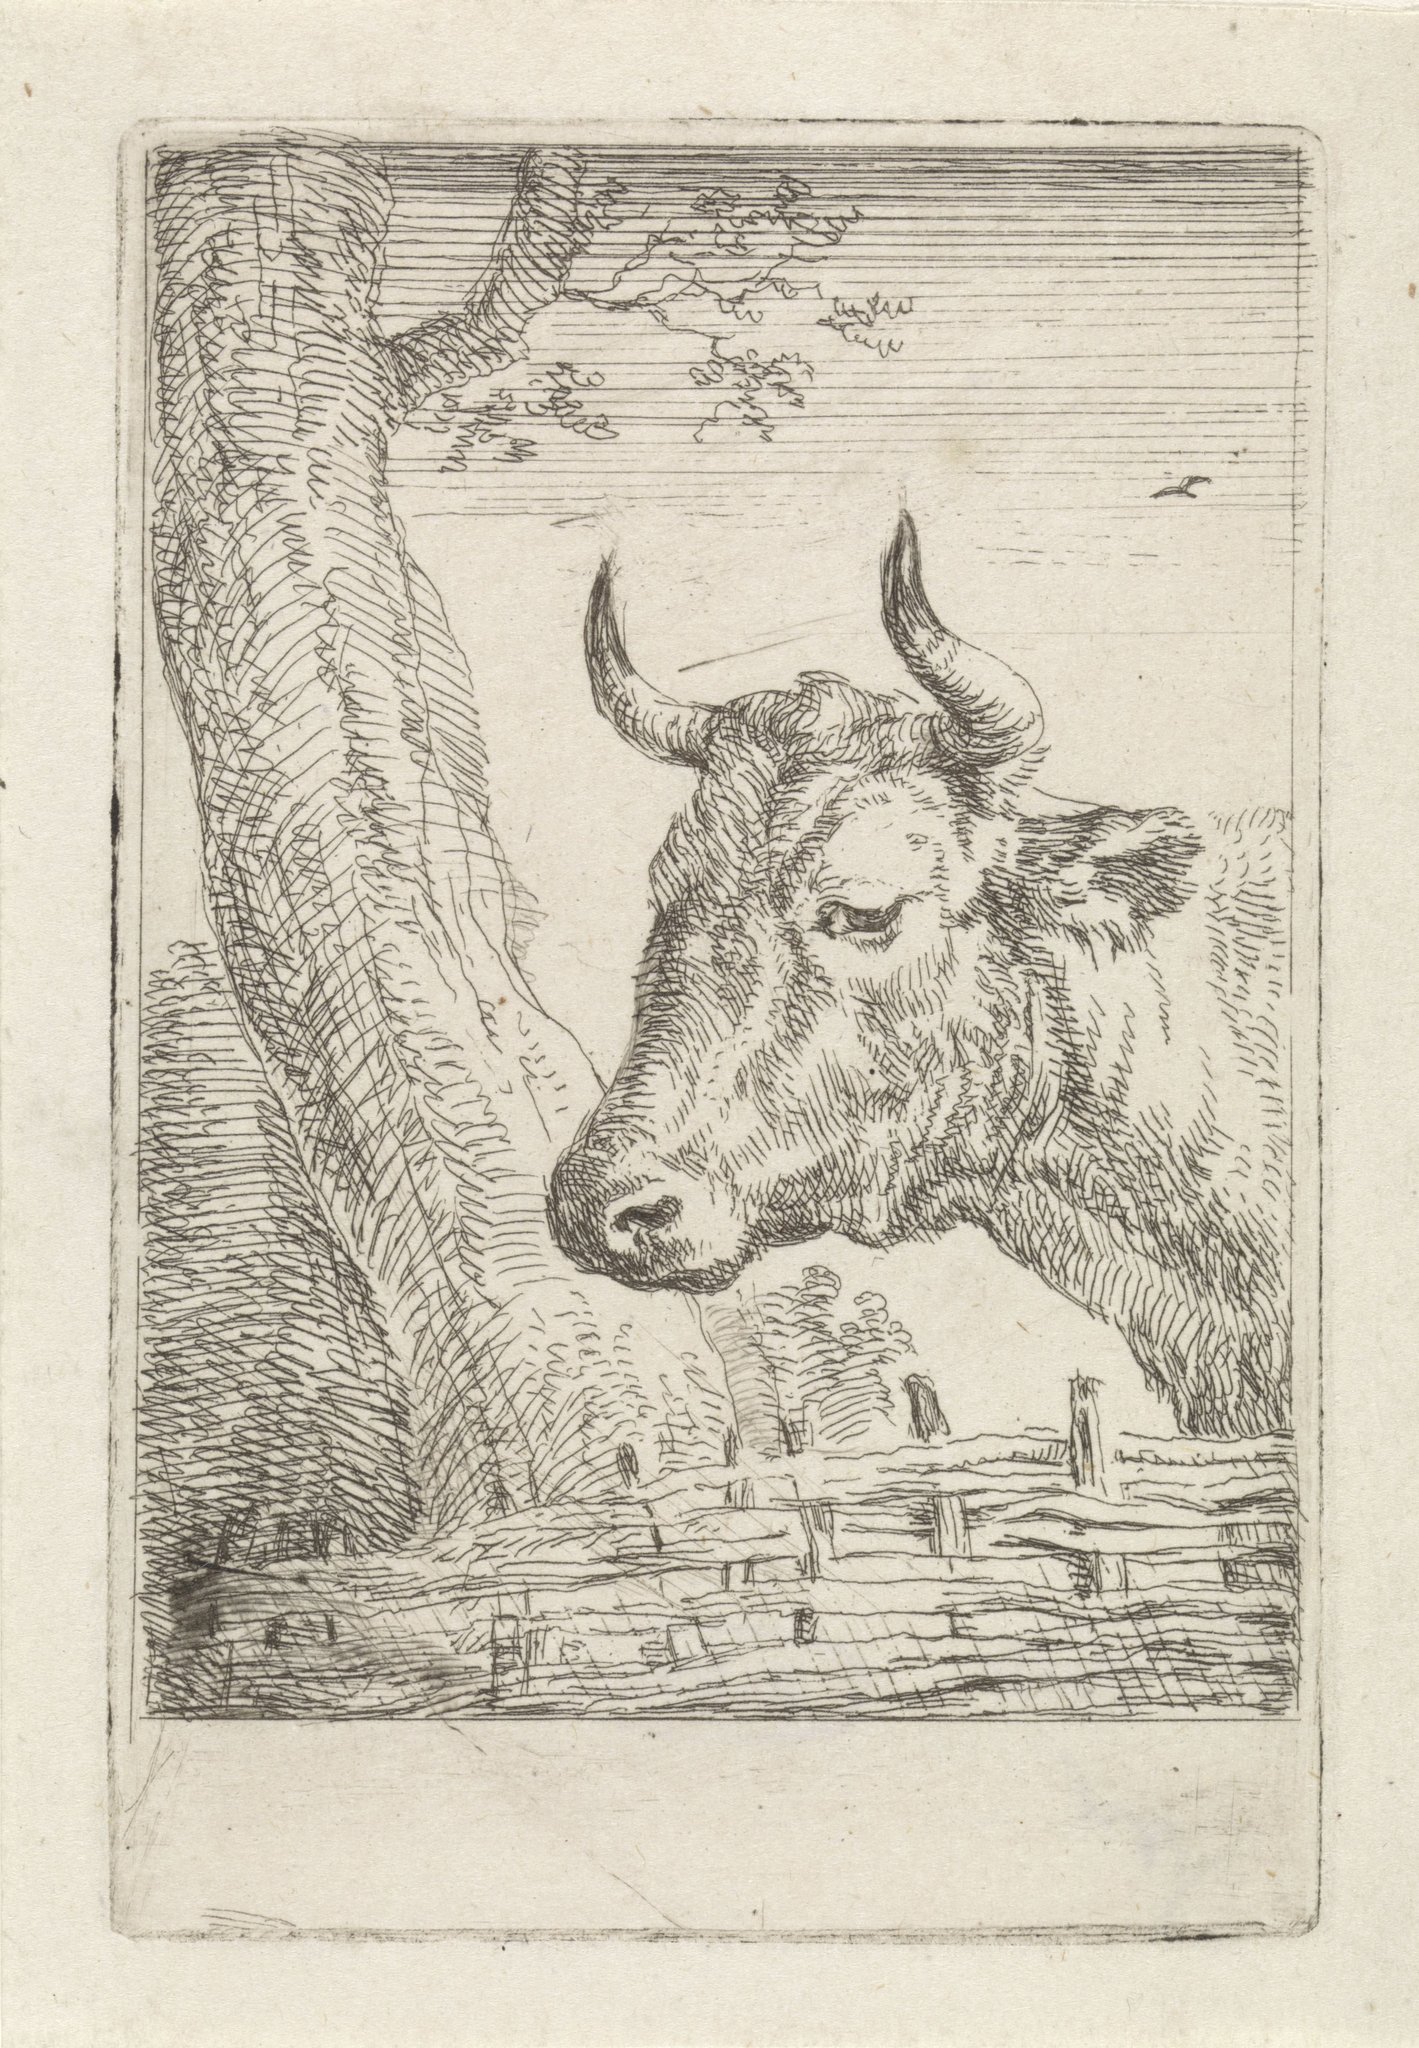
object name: print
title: Koe bij een wilgentenen omheining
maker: aert schouman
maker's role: draughtsman, painter, print maker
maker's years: 1710-1792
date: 1725-1792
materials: paper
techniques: etching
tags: cow, fence, wall, paling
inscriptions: collector's mark: Lugt 2228